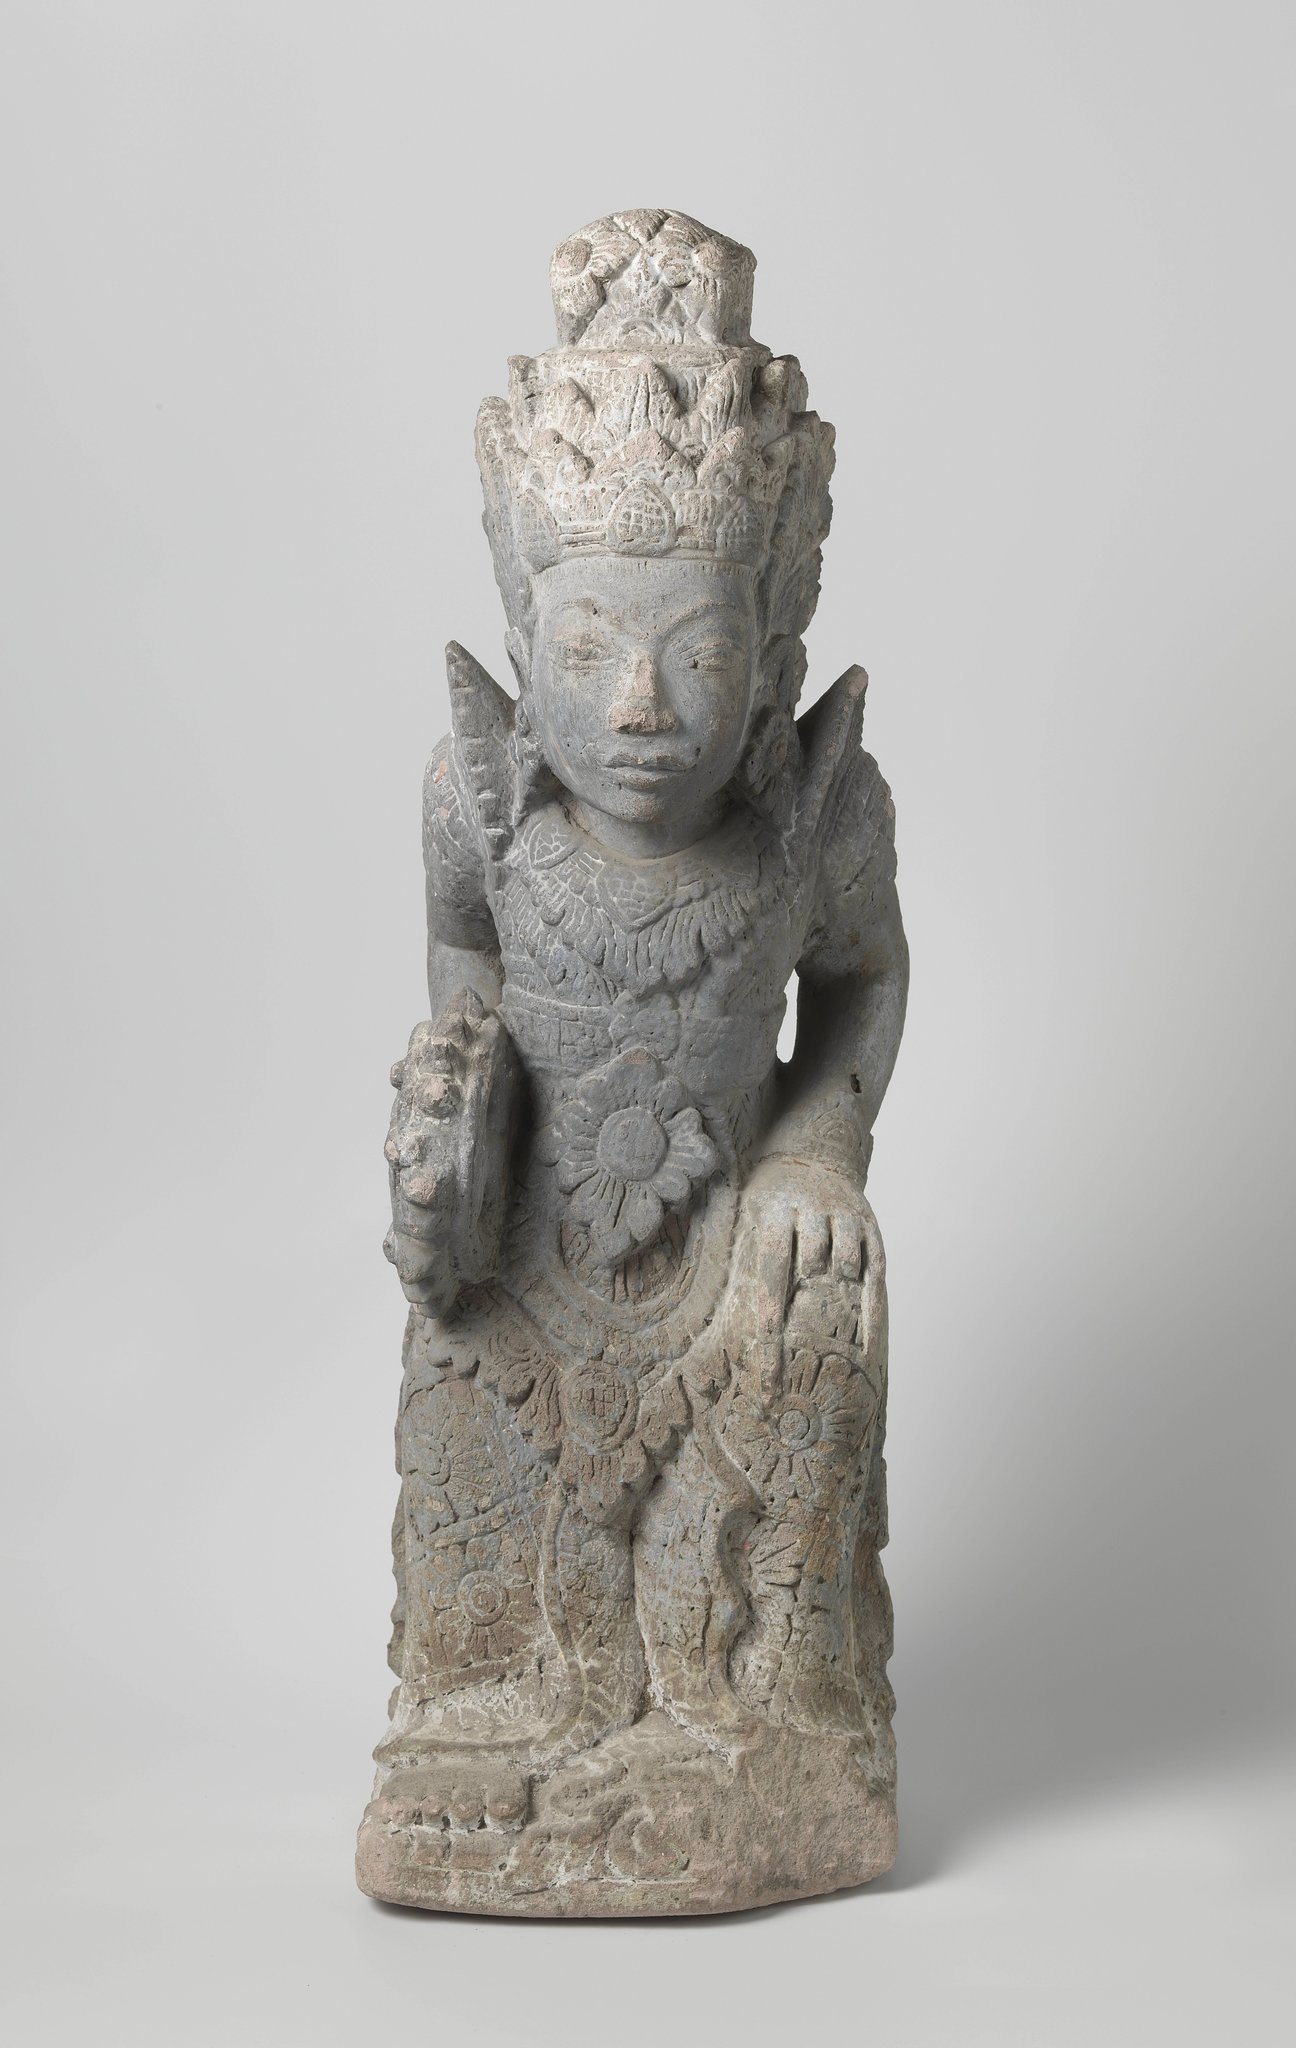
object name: visjnoe, visnu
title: Sculptuur van Visnu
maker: Anonymous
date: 1900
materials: dye, stone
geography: bali